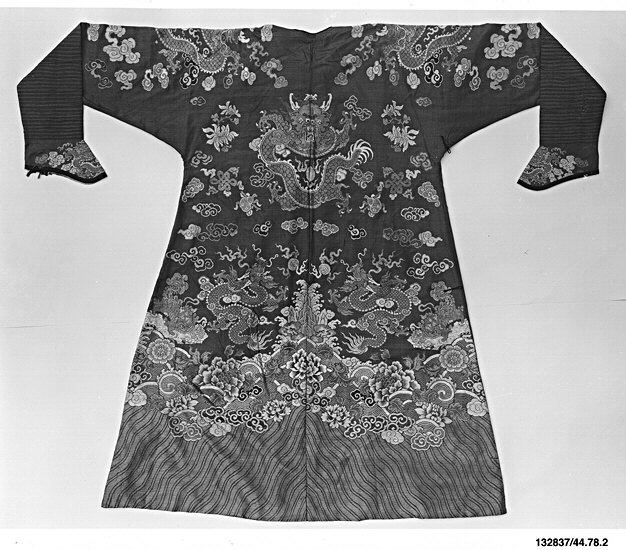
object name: robe, court, summer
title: Summer Court Robe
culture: chinese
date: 1908-1911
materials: metal thread, silk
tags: dragons